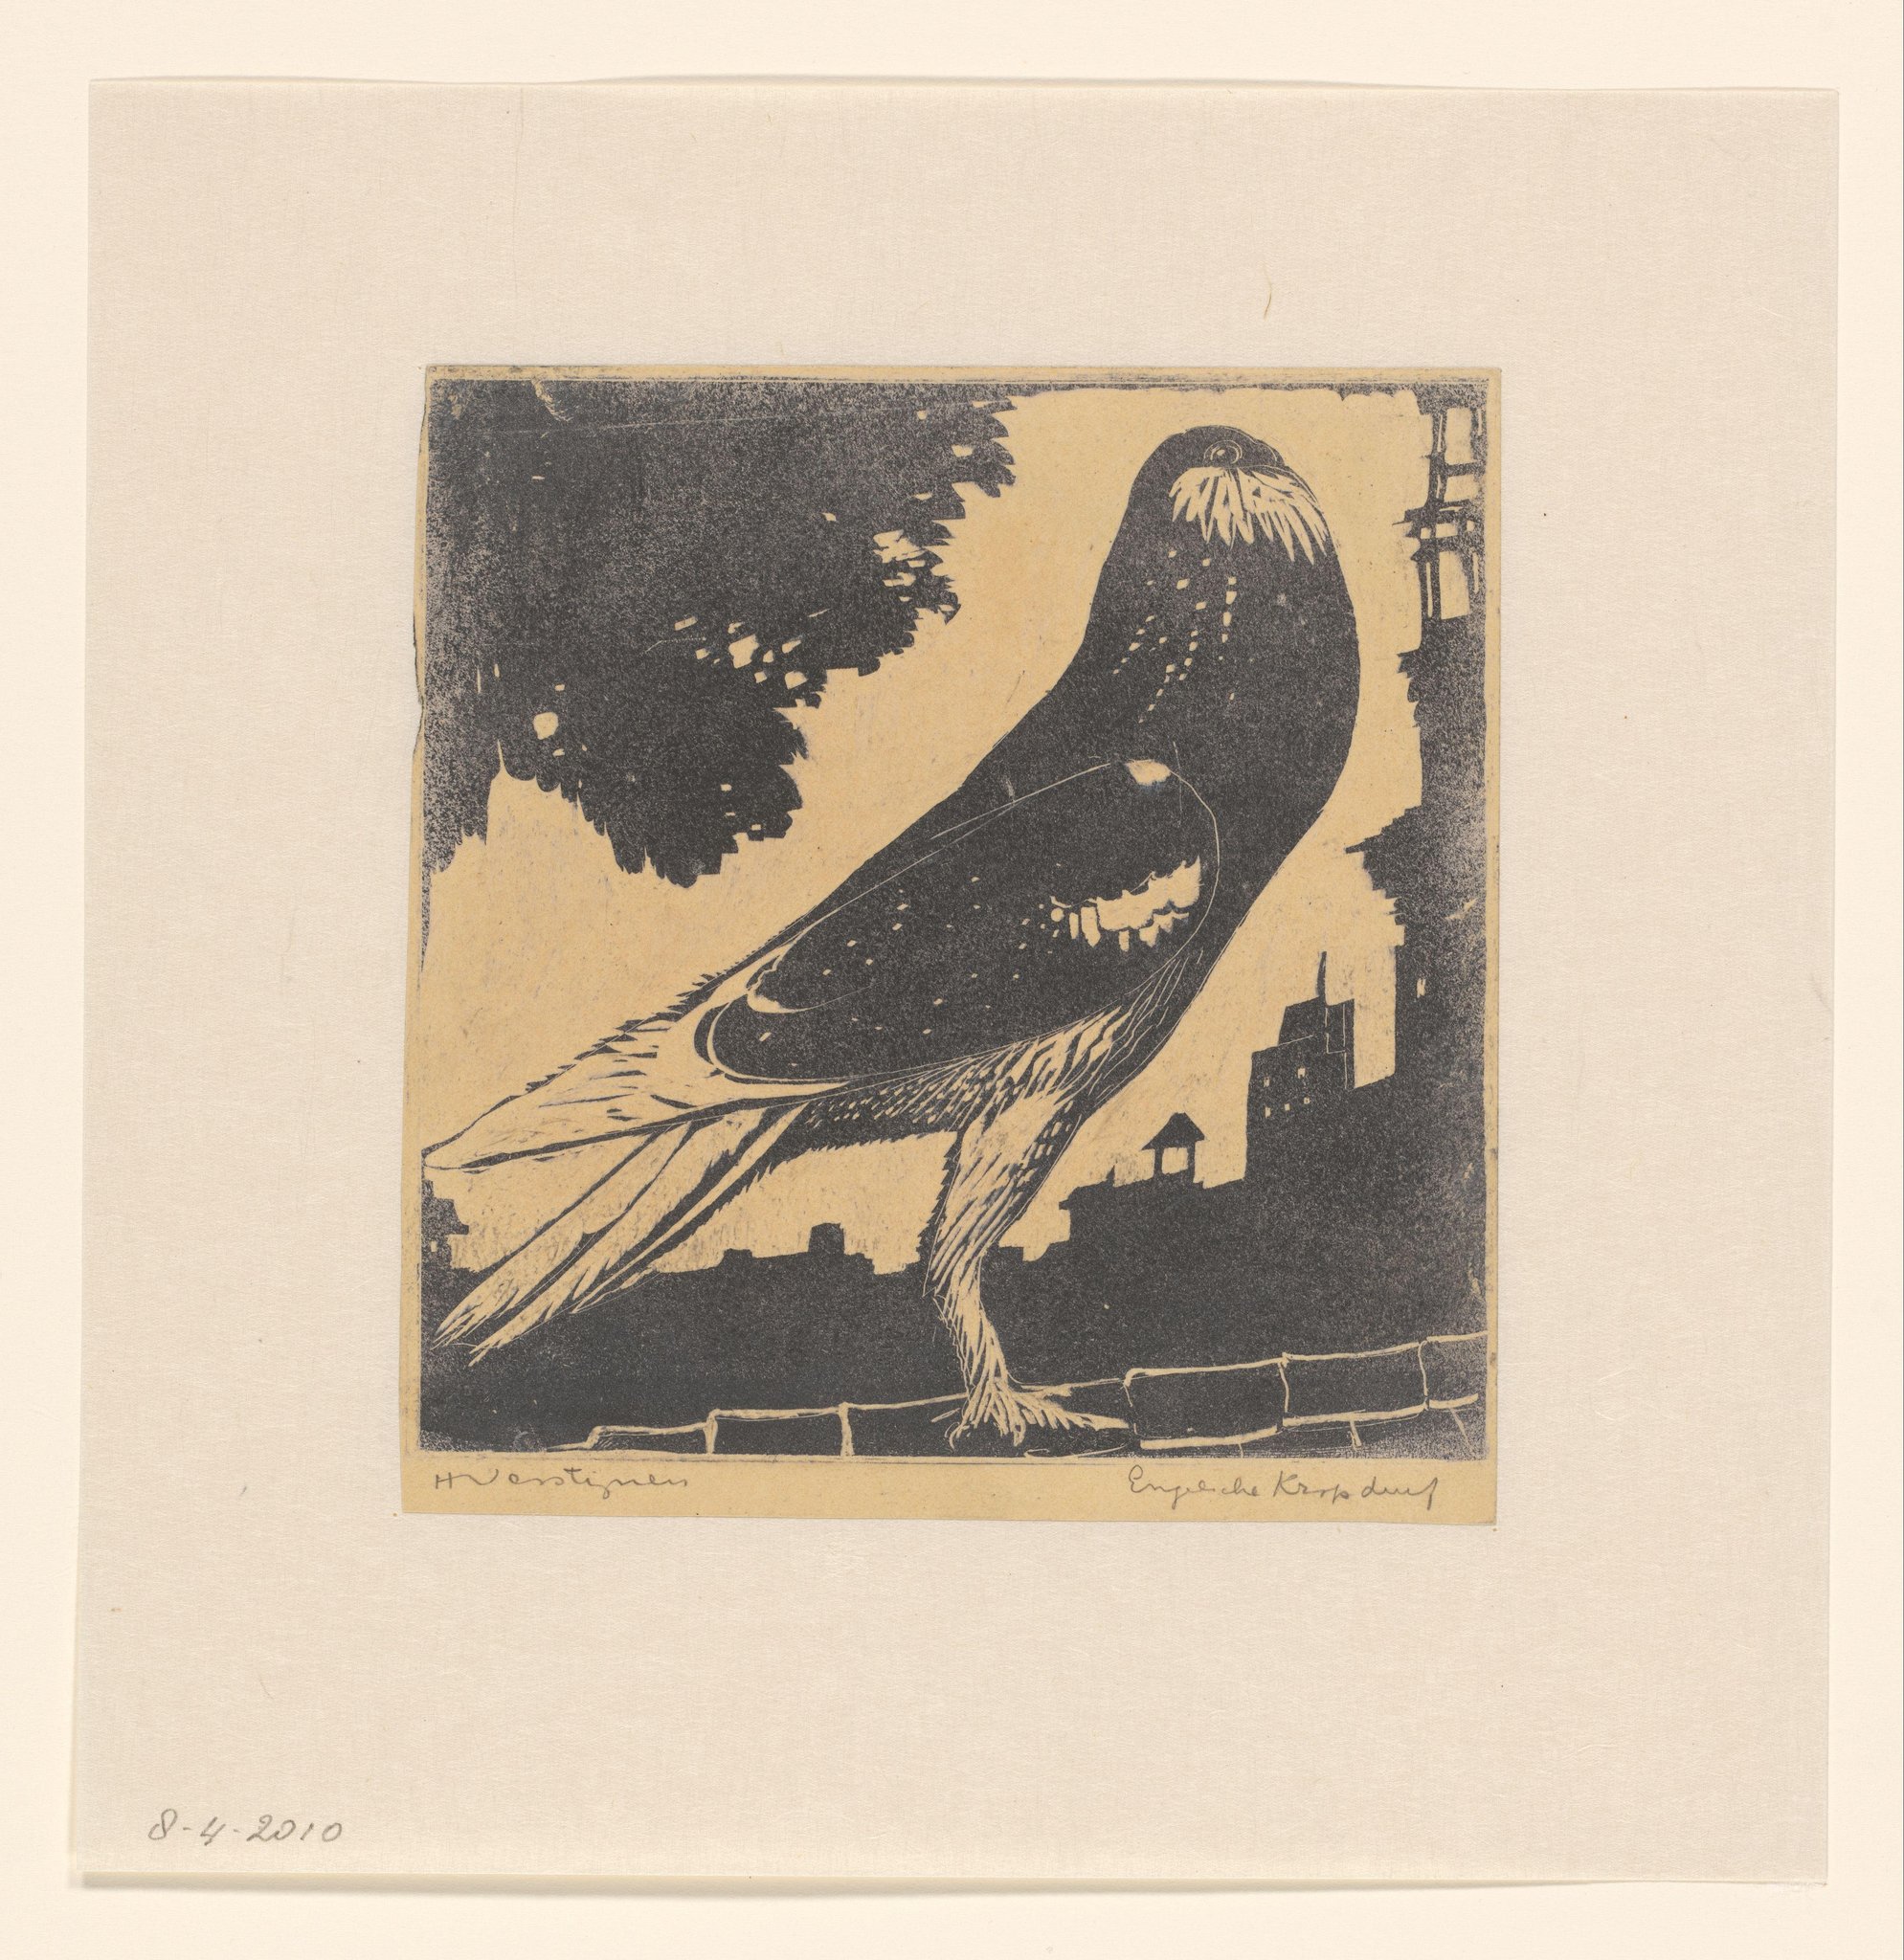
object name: print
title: Engelse Kropduif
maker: henri verstijnen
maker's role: draughtsman, print maker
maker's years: 1882-1940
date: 1892-1940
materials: paper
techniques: linocut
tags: doves, pigeons